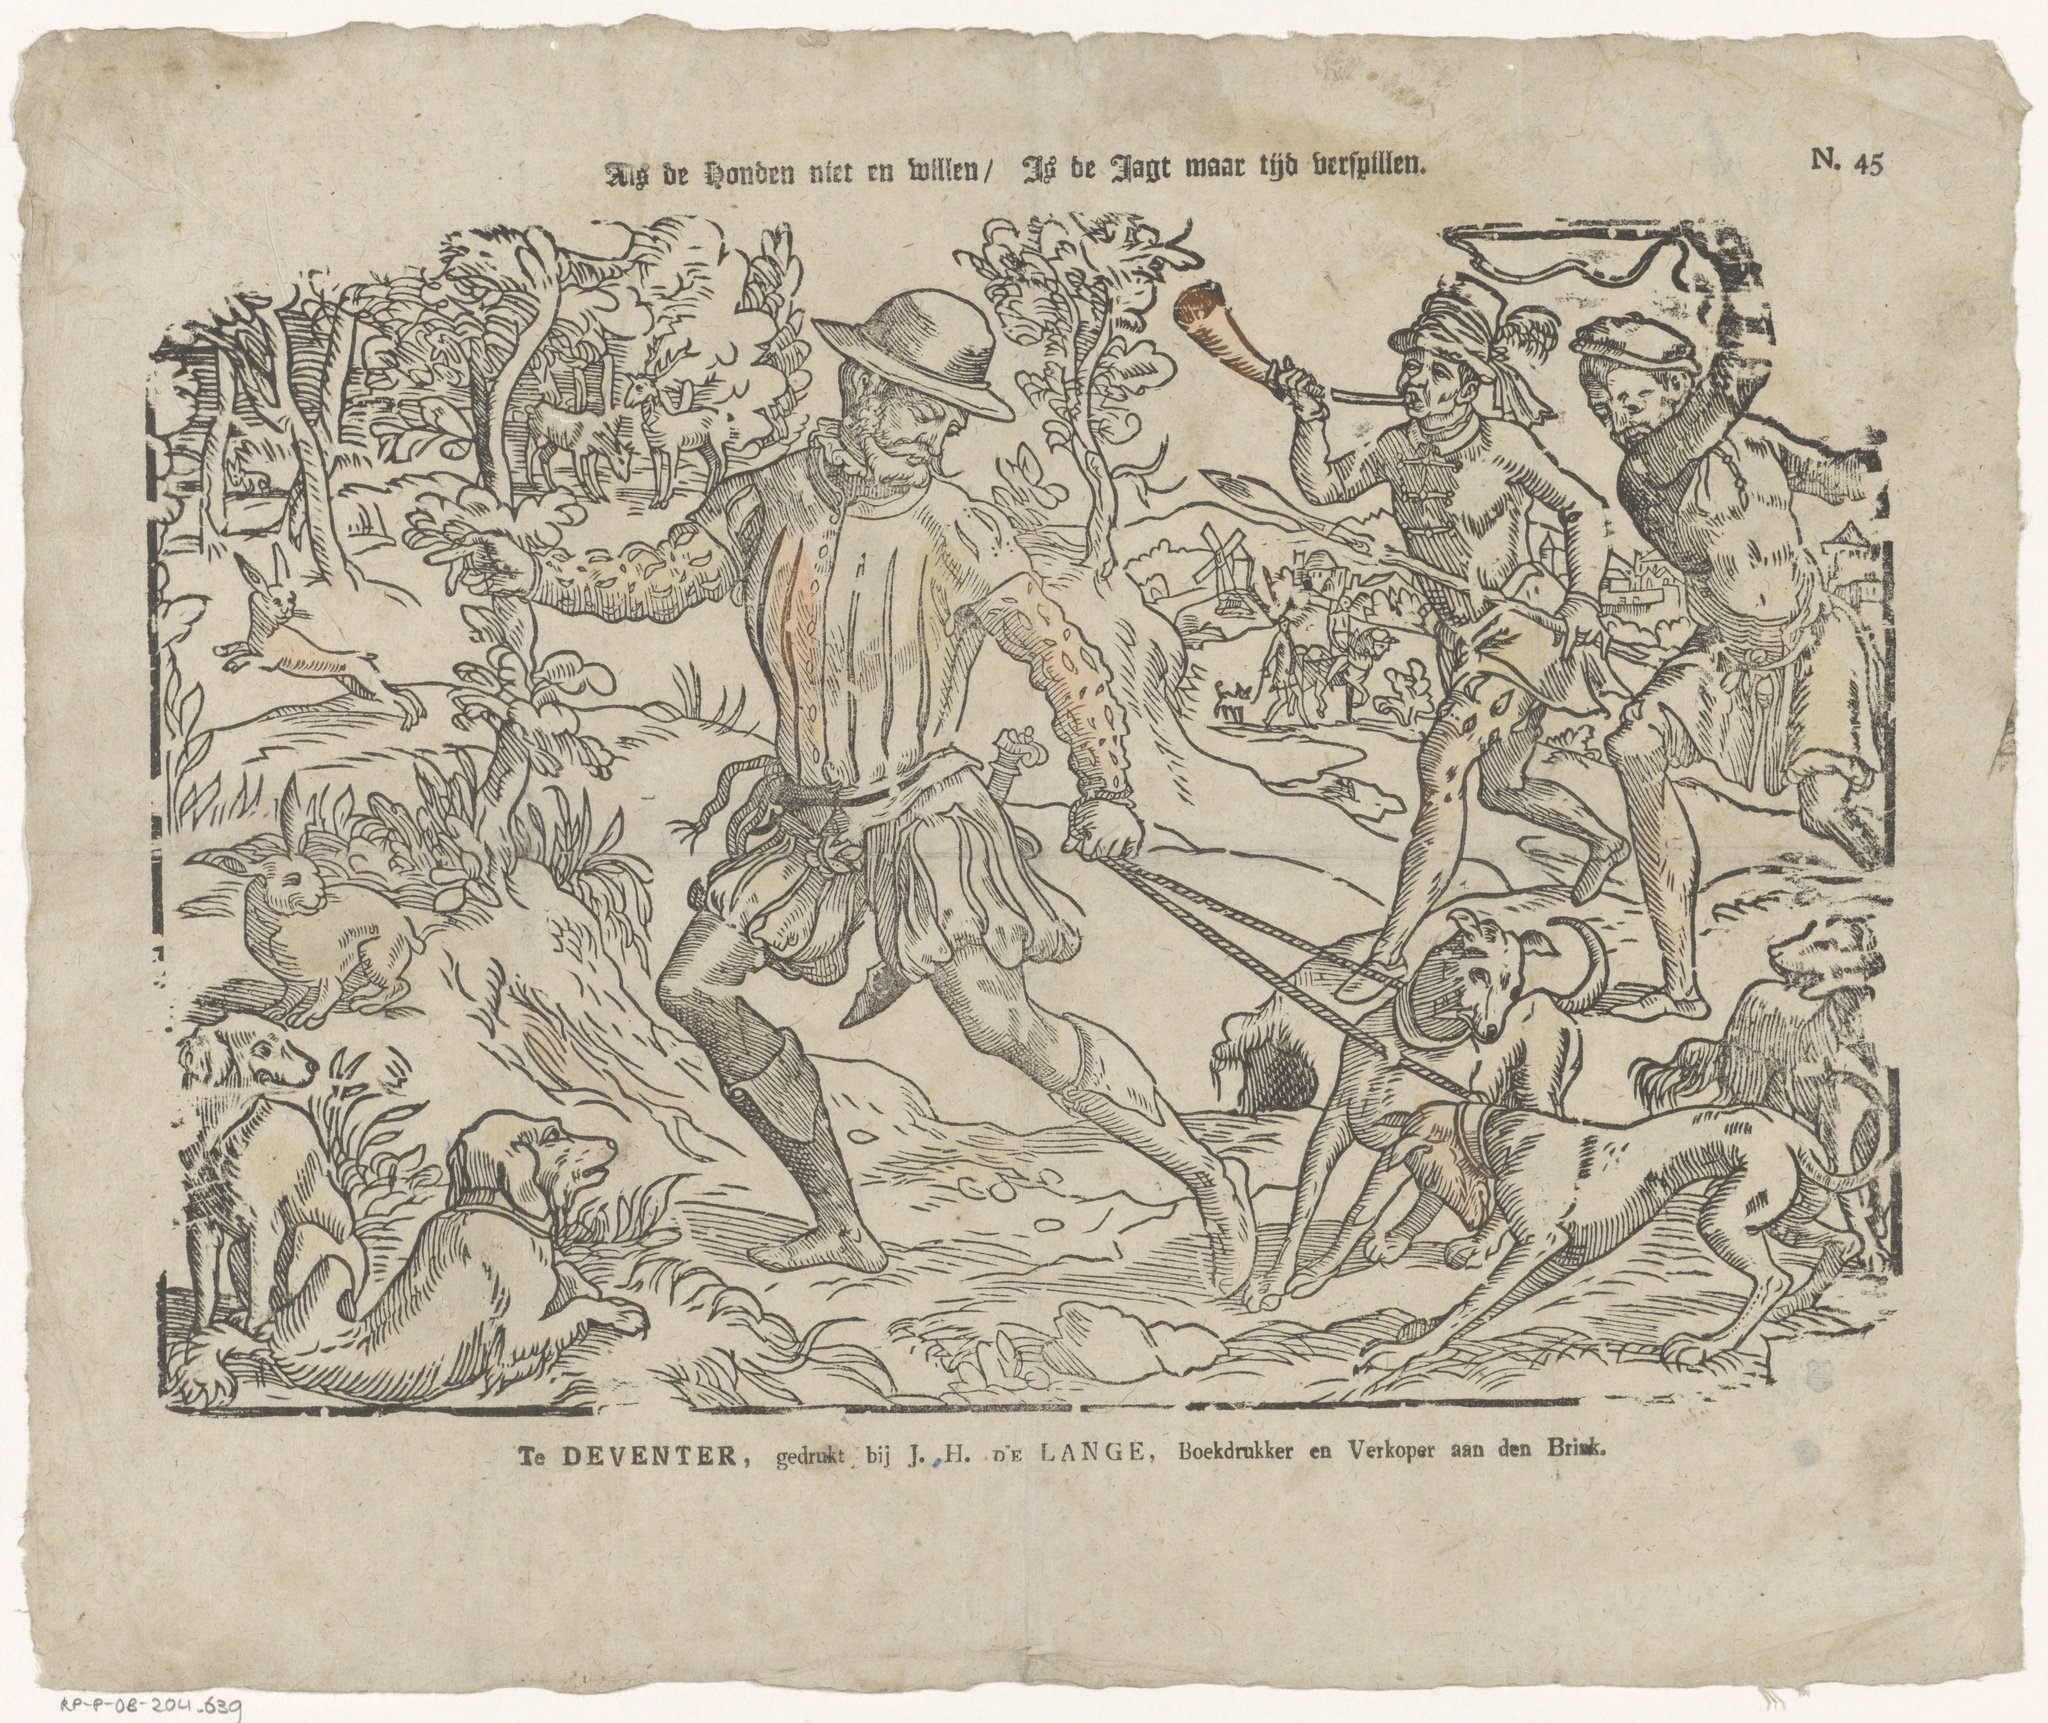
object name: print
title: Als de honden niet en willen / Is de jagt maar tijd verspillen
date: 1550-1600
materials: paper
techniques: colour, letterpress printing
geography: netherlands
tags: hunting dogs, hunter, hunters hunting (n.b.: in 1988-1990 this notation denoted the concept of 43c11421 'hunters resting during the hunt'), proverbs, sayings, etc.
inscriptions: collector's mark: Lugt 2760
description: Blad met een grote jachtvoorstelling. Drie jagers in een landschap. Hun honden stribbelen tegen. Op de achtergrond hazen en herten. Verbeelding van het spreekwoord: met onwillige honden is het kwaad hazen vangen. Genummerd rechtsboven: N. 45.